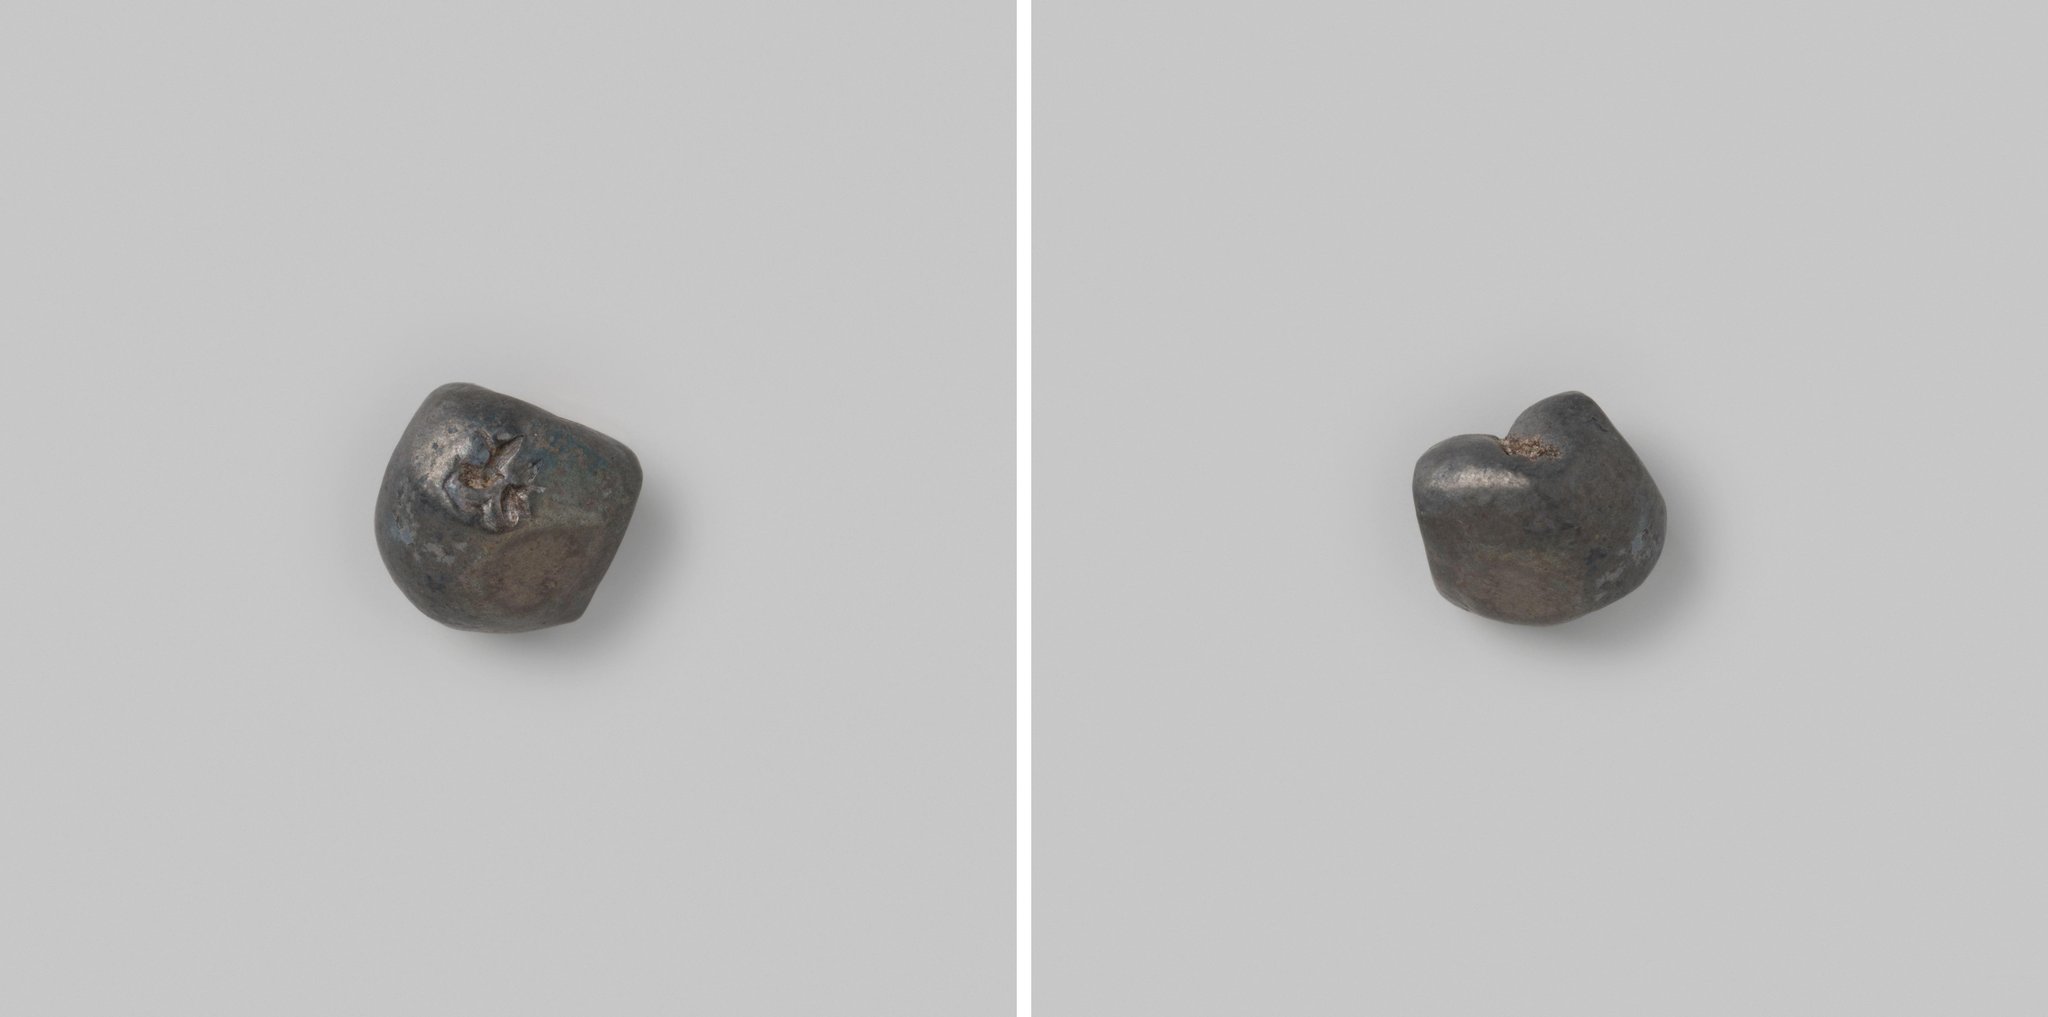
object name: coin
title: 1/8 tical of fuang uit Thailand,1650-1850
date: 1650-1850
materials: silver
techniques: casting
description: Zilveren, korrelvormige munt. voorzien van één instempeling (kra): bai matum [=bale fruit tree] [?].